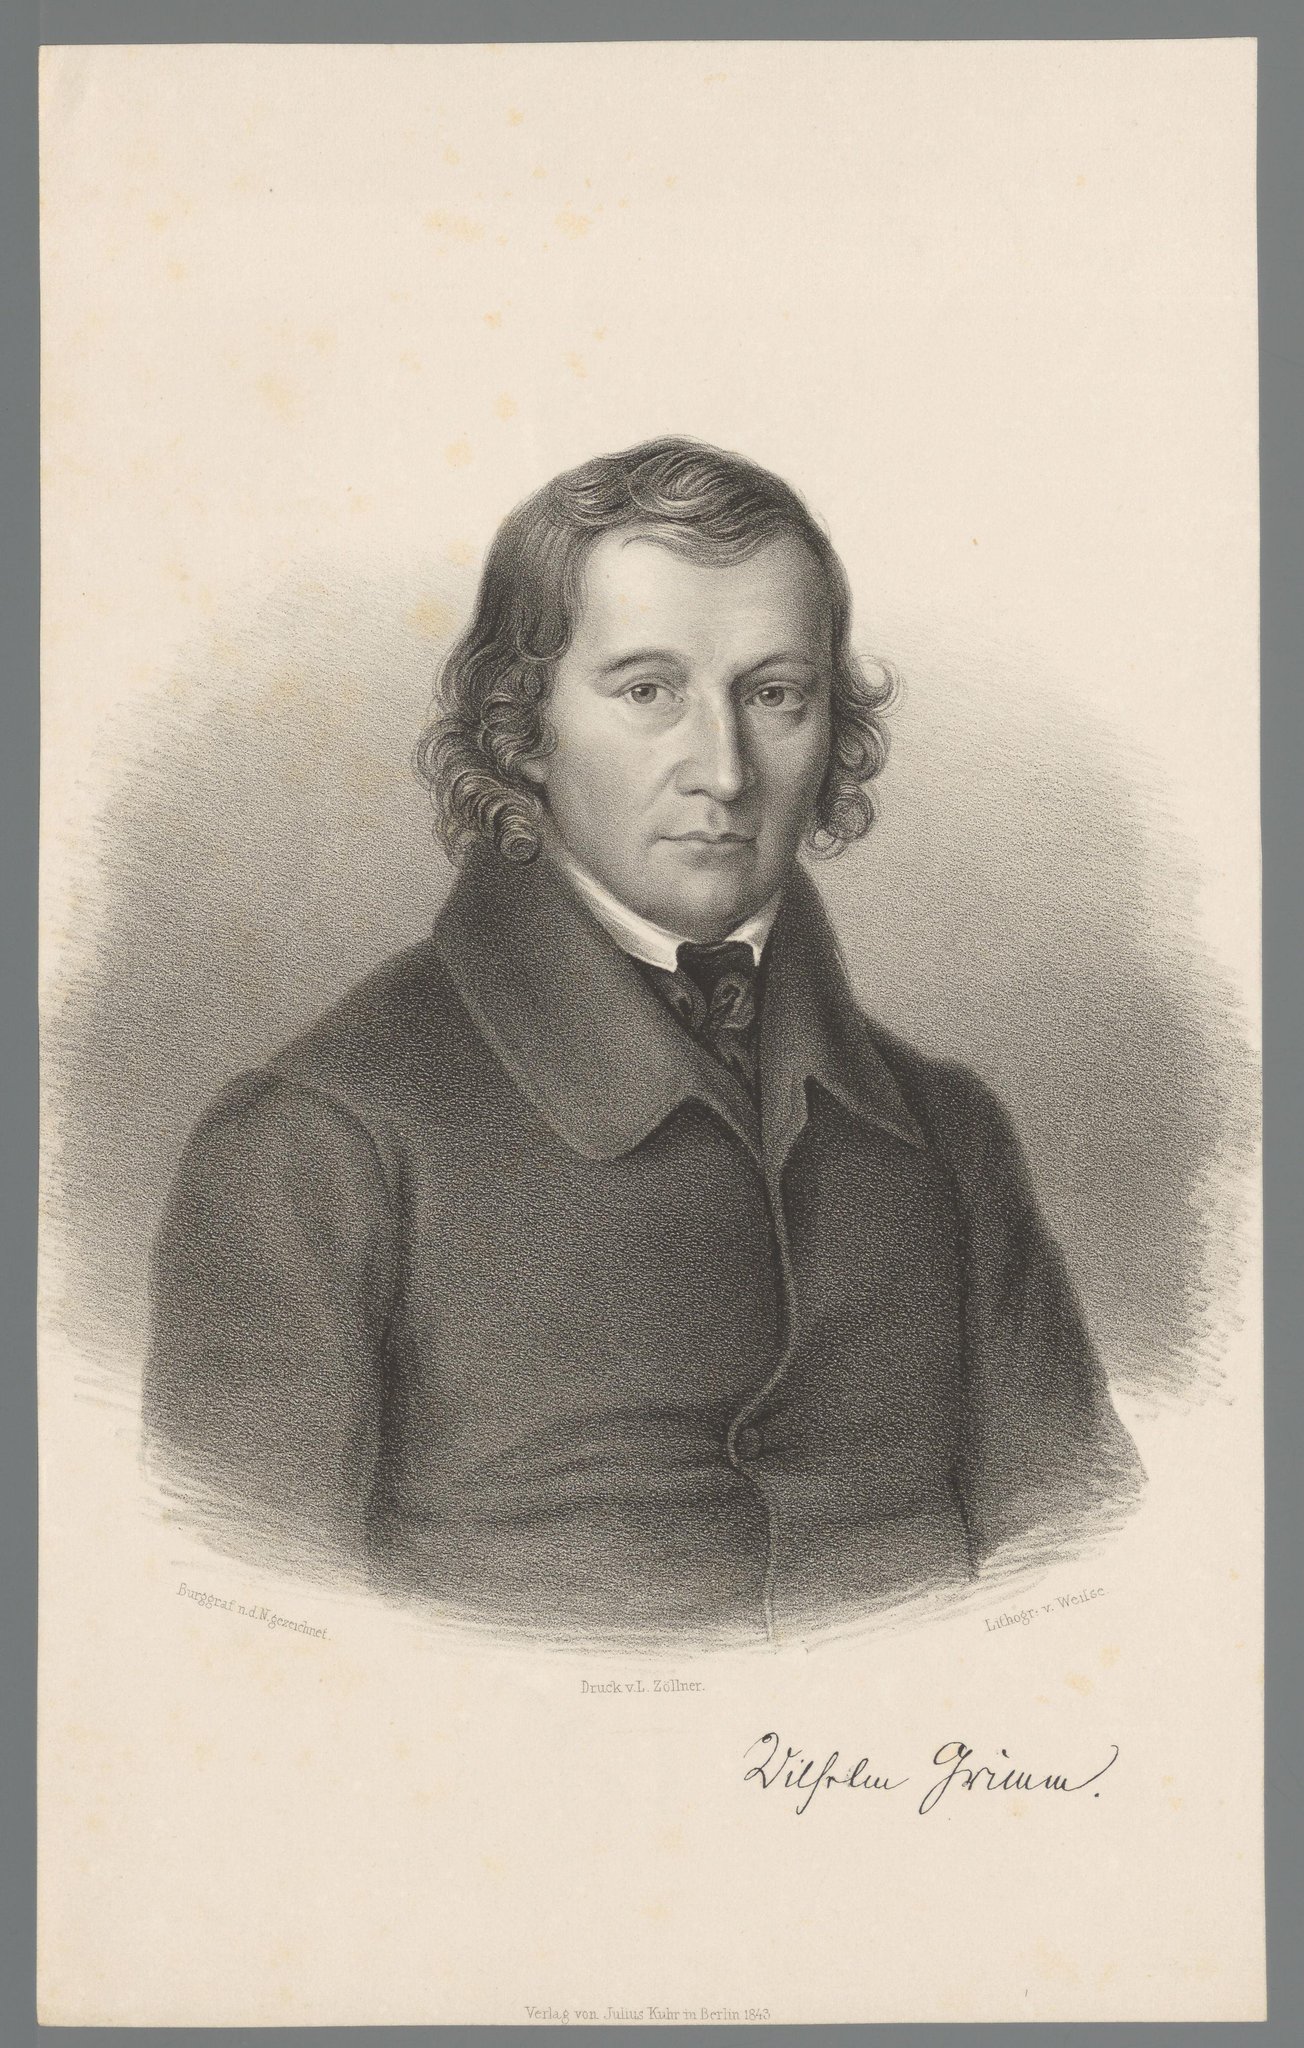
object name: print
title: Portret van Wilhelm Grimm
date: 1843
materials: paper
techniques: lithograph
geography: berlin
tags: berlin, adult man, historical persons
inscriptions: collector's mark: Lugt 2228